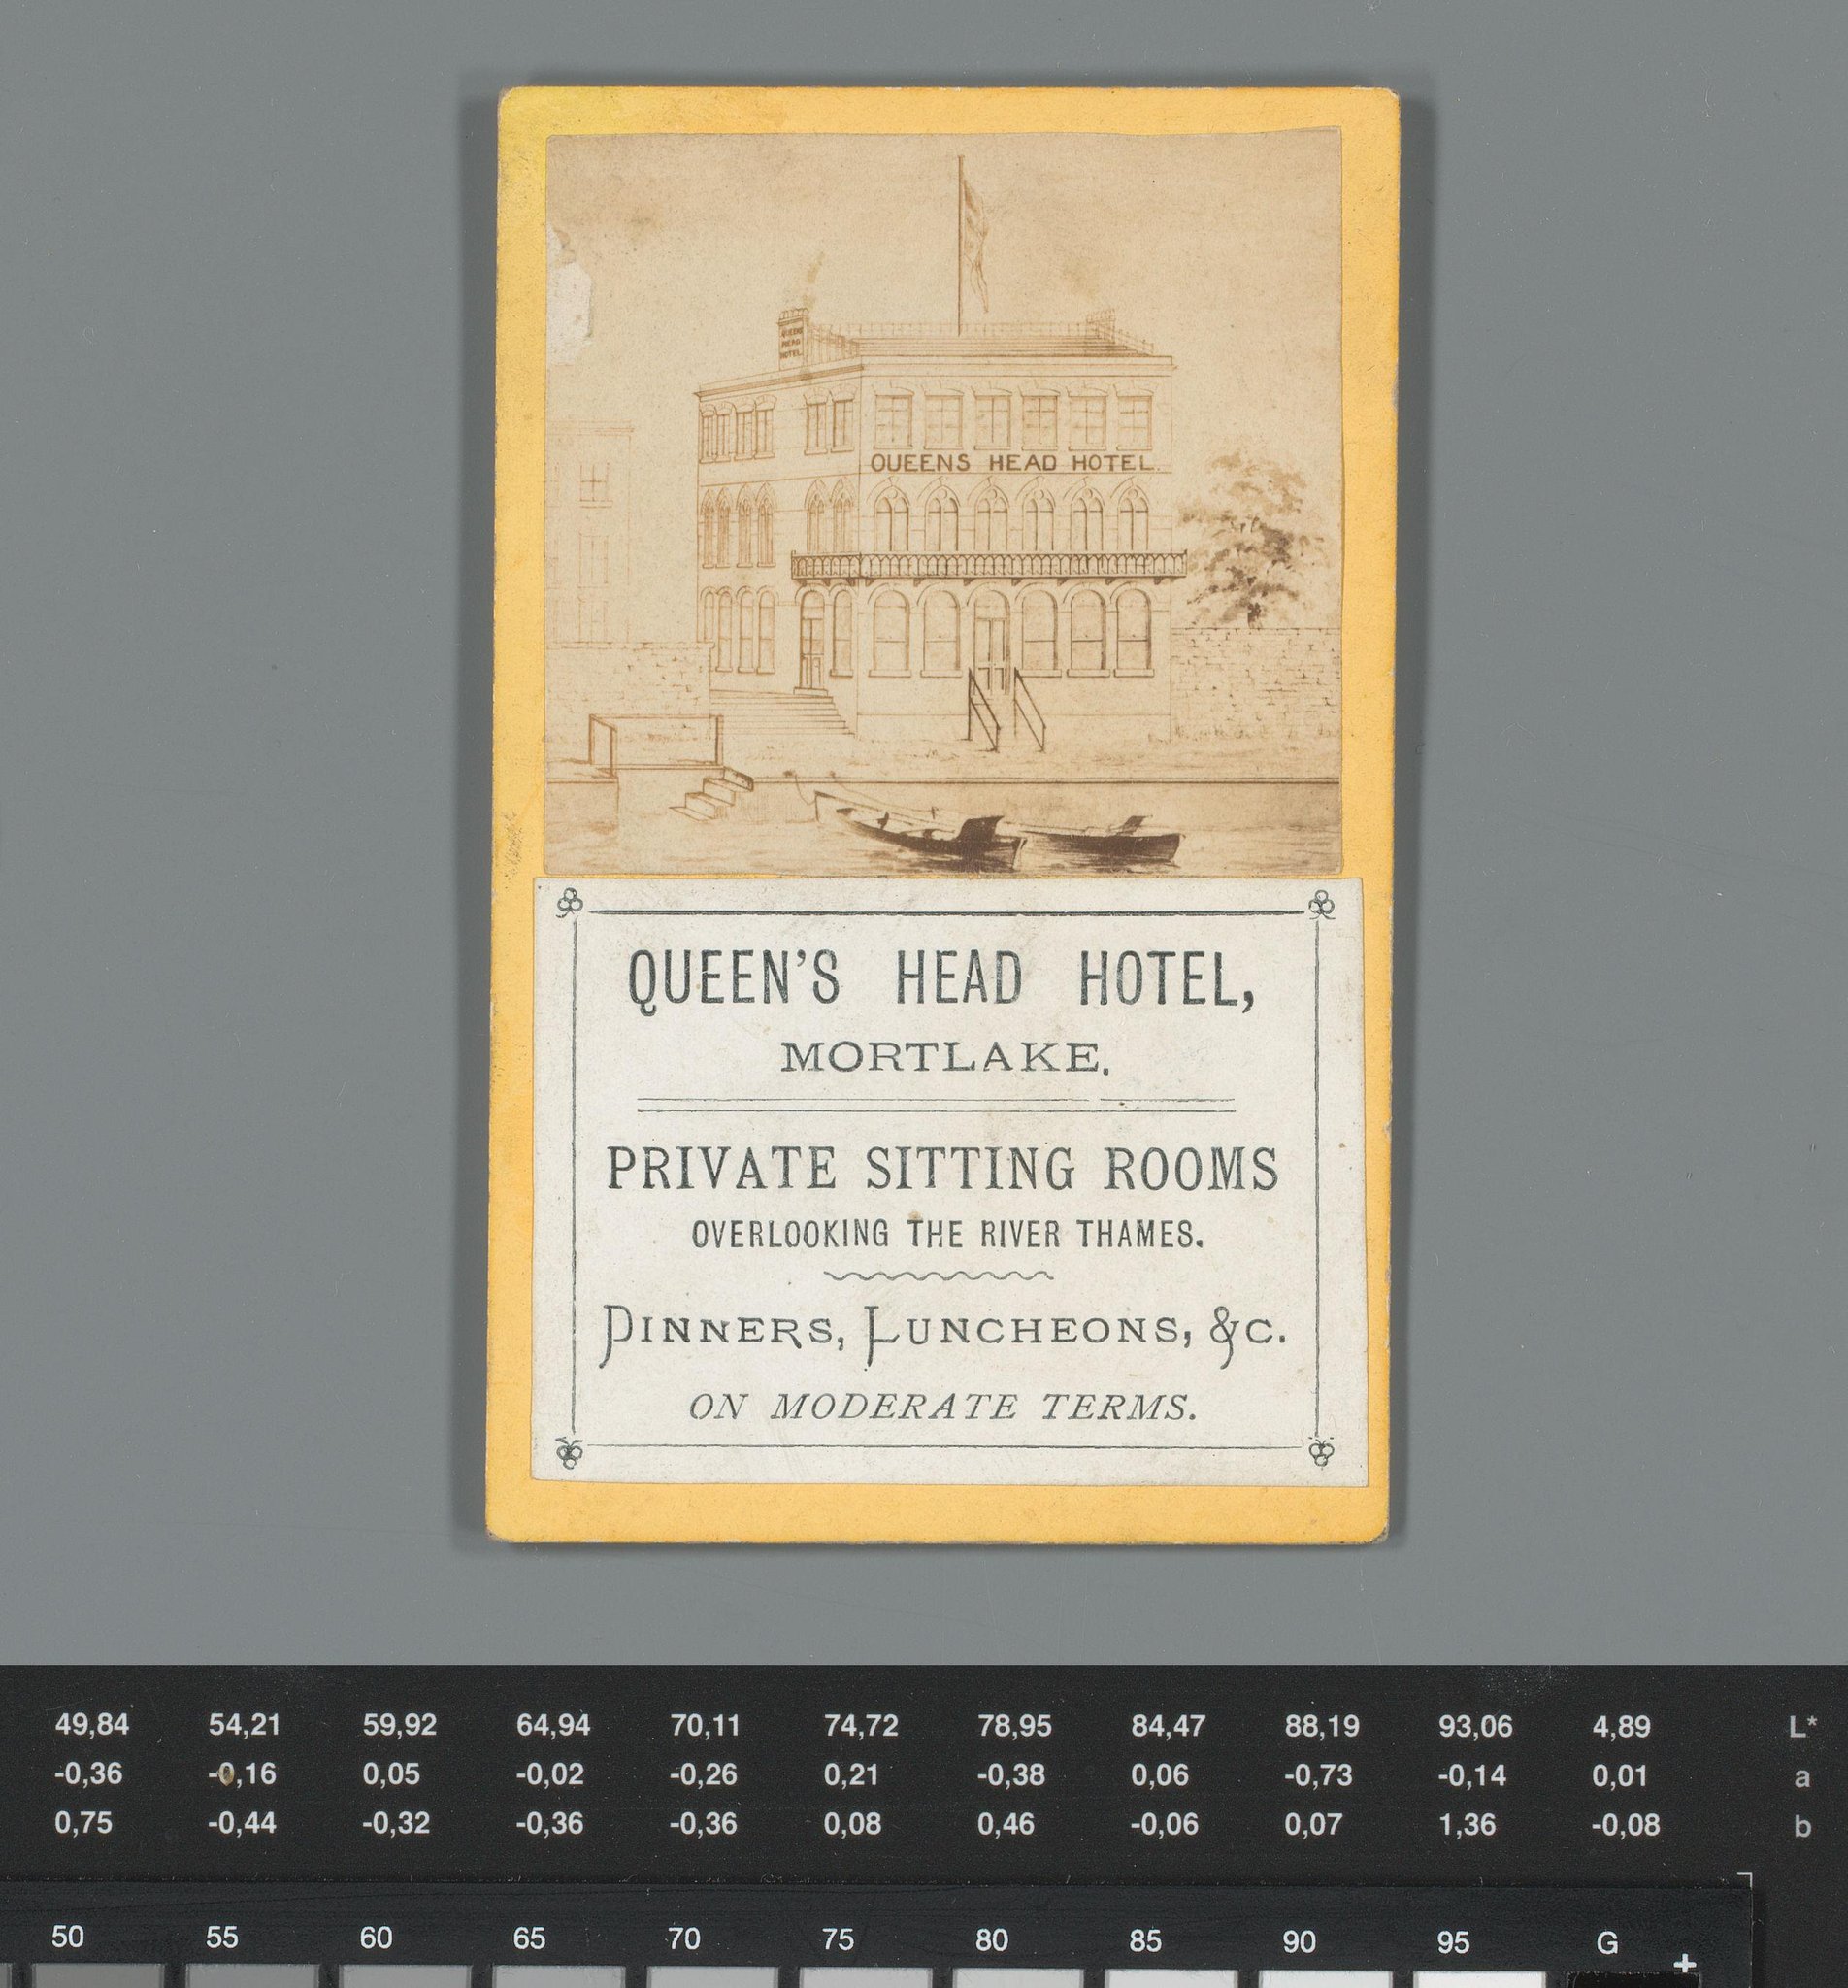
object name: reproduction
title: Reclame voor het Queen's Head Hotel in Mortlake, Engeland, met fotoreproductie van een prent van het hotel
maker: Anonymous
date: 1850-1915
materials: cardboard, photographic support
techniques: albumen print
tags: advertising, hotel, hostelry, inn